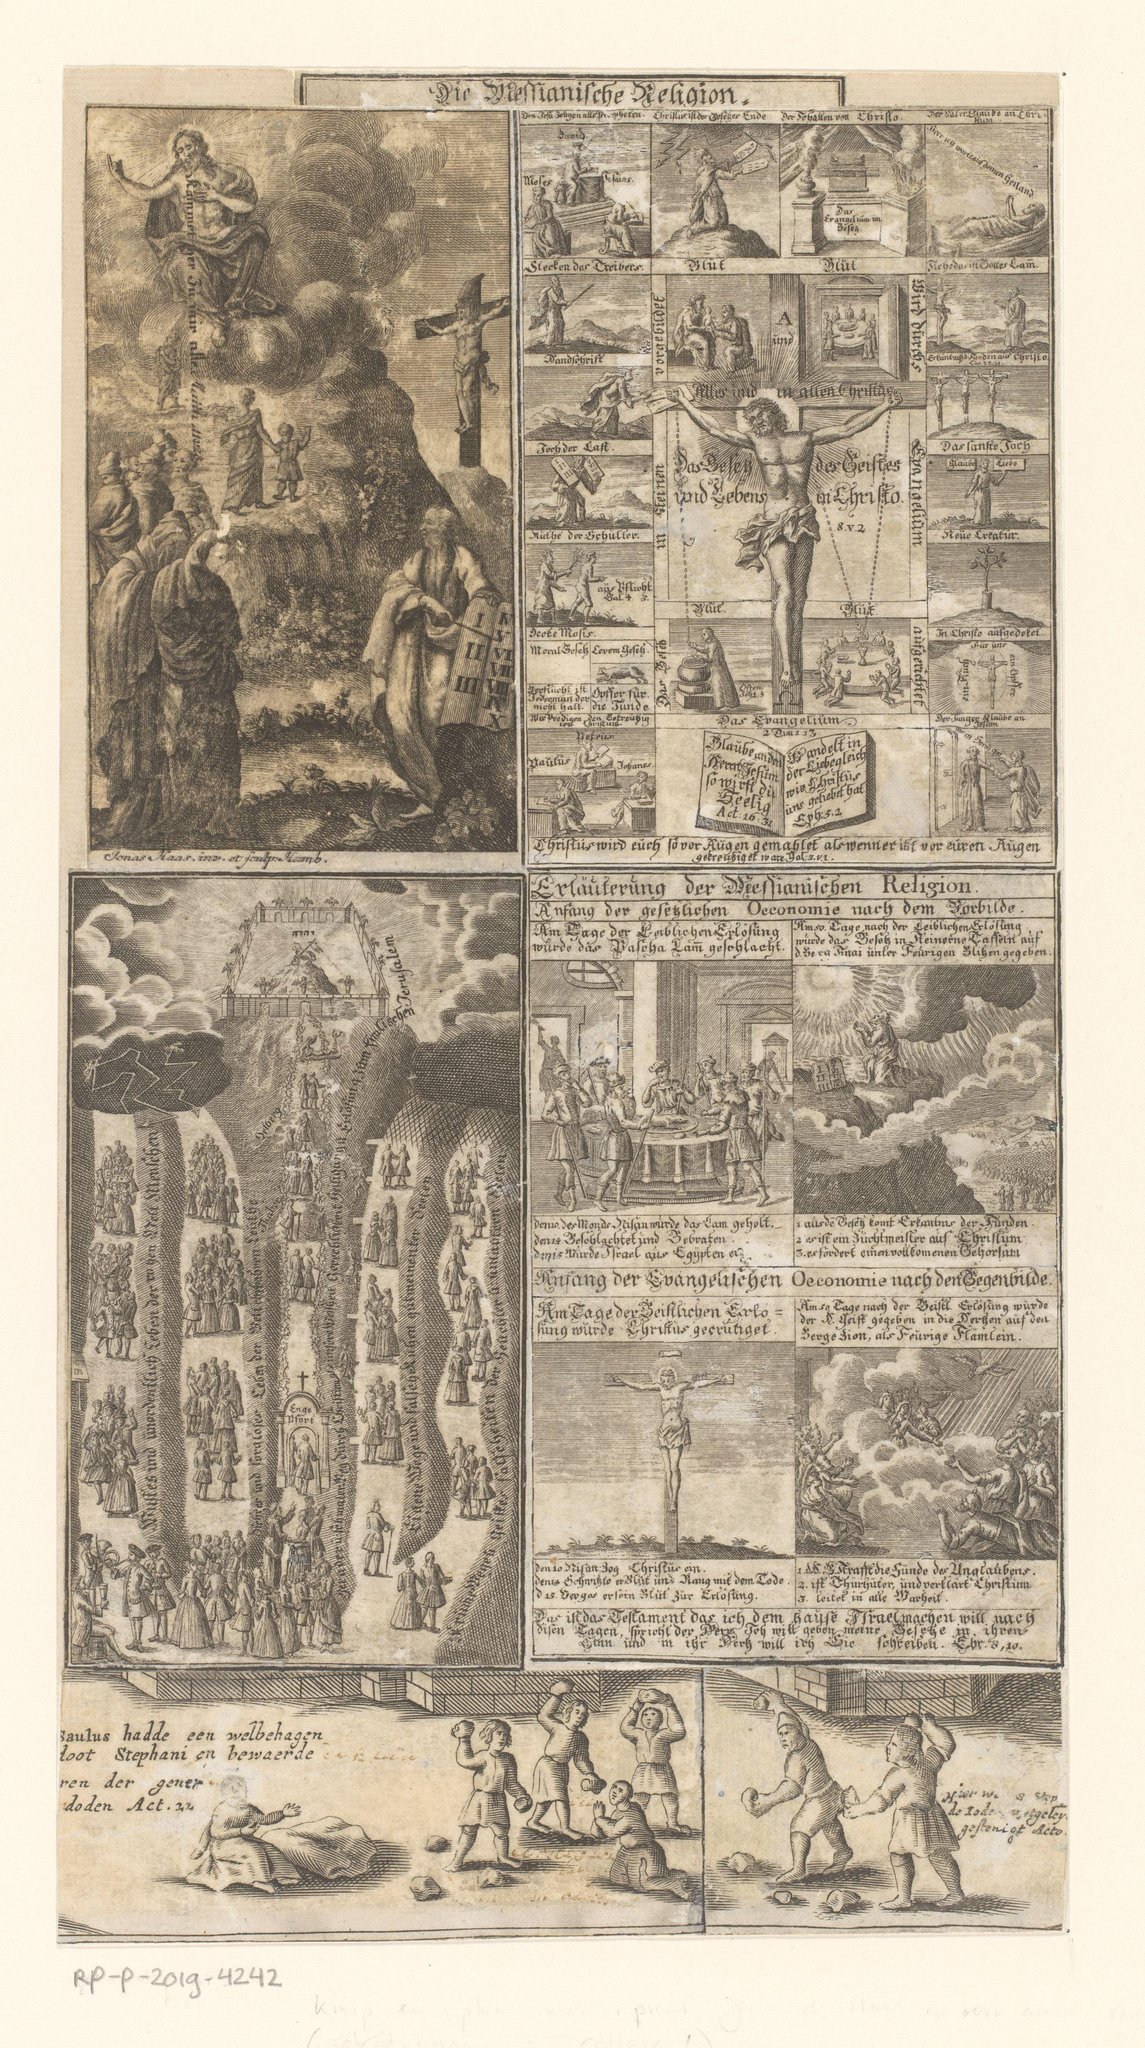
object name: collage visual work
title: Collage van vijf prenten met Bijbelse scènes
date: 1730-1775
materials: paper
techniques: engraving, etching, snipping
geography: low countries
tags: the stoning of stephen; the witnesses lay down their clothes at saul's feet, sacrifice of the paschal lamb ~ jewish religion, moses receives the tables of the law from god, the way to destruction is broad and the gate is wide; the way to life is narrow and the gate is straight ~ doctrine of christ on love, etc. (matthew 7:13-14; luke 13:24), christ on the cross combined with other scenes from the passion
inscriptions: collector's mark: Lugt 2228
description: Linksboven een prent van Jonas Haas (1720-1775). De andere prenten zijn anoniem Duits en Nederlands, zeventiende- of achttiende-eeuws. Linksboven: voorstelling met Mozes met de tien geboden, Kruisiging van Christus en mogelijk Christus die figuren toelaat in de hemel. Rechtsboven: prent met kruisiging van Christus en rondom verschillende kleine Bijbelse voorstellingen. Linksonder: prent met de smalle weg naar Jeruzalem en de brede weg naar vernietiging. Rechtsonder: prent met vier voorstellingen uit het Oude en Nieuwe Testament, namelijk het offeren van het Paaslam, Mozes met de tien geboden op de Sinaïberg, de Kruisiging van Christus en mogelijk een tenhemelopneming. Helemaal onder: prent met Steniging van Stefanus.